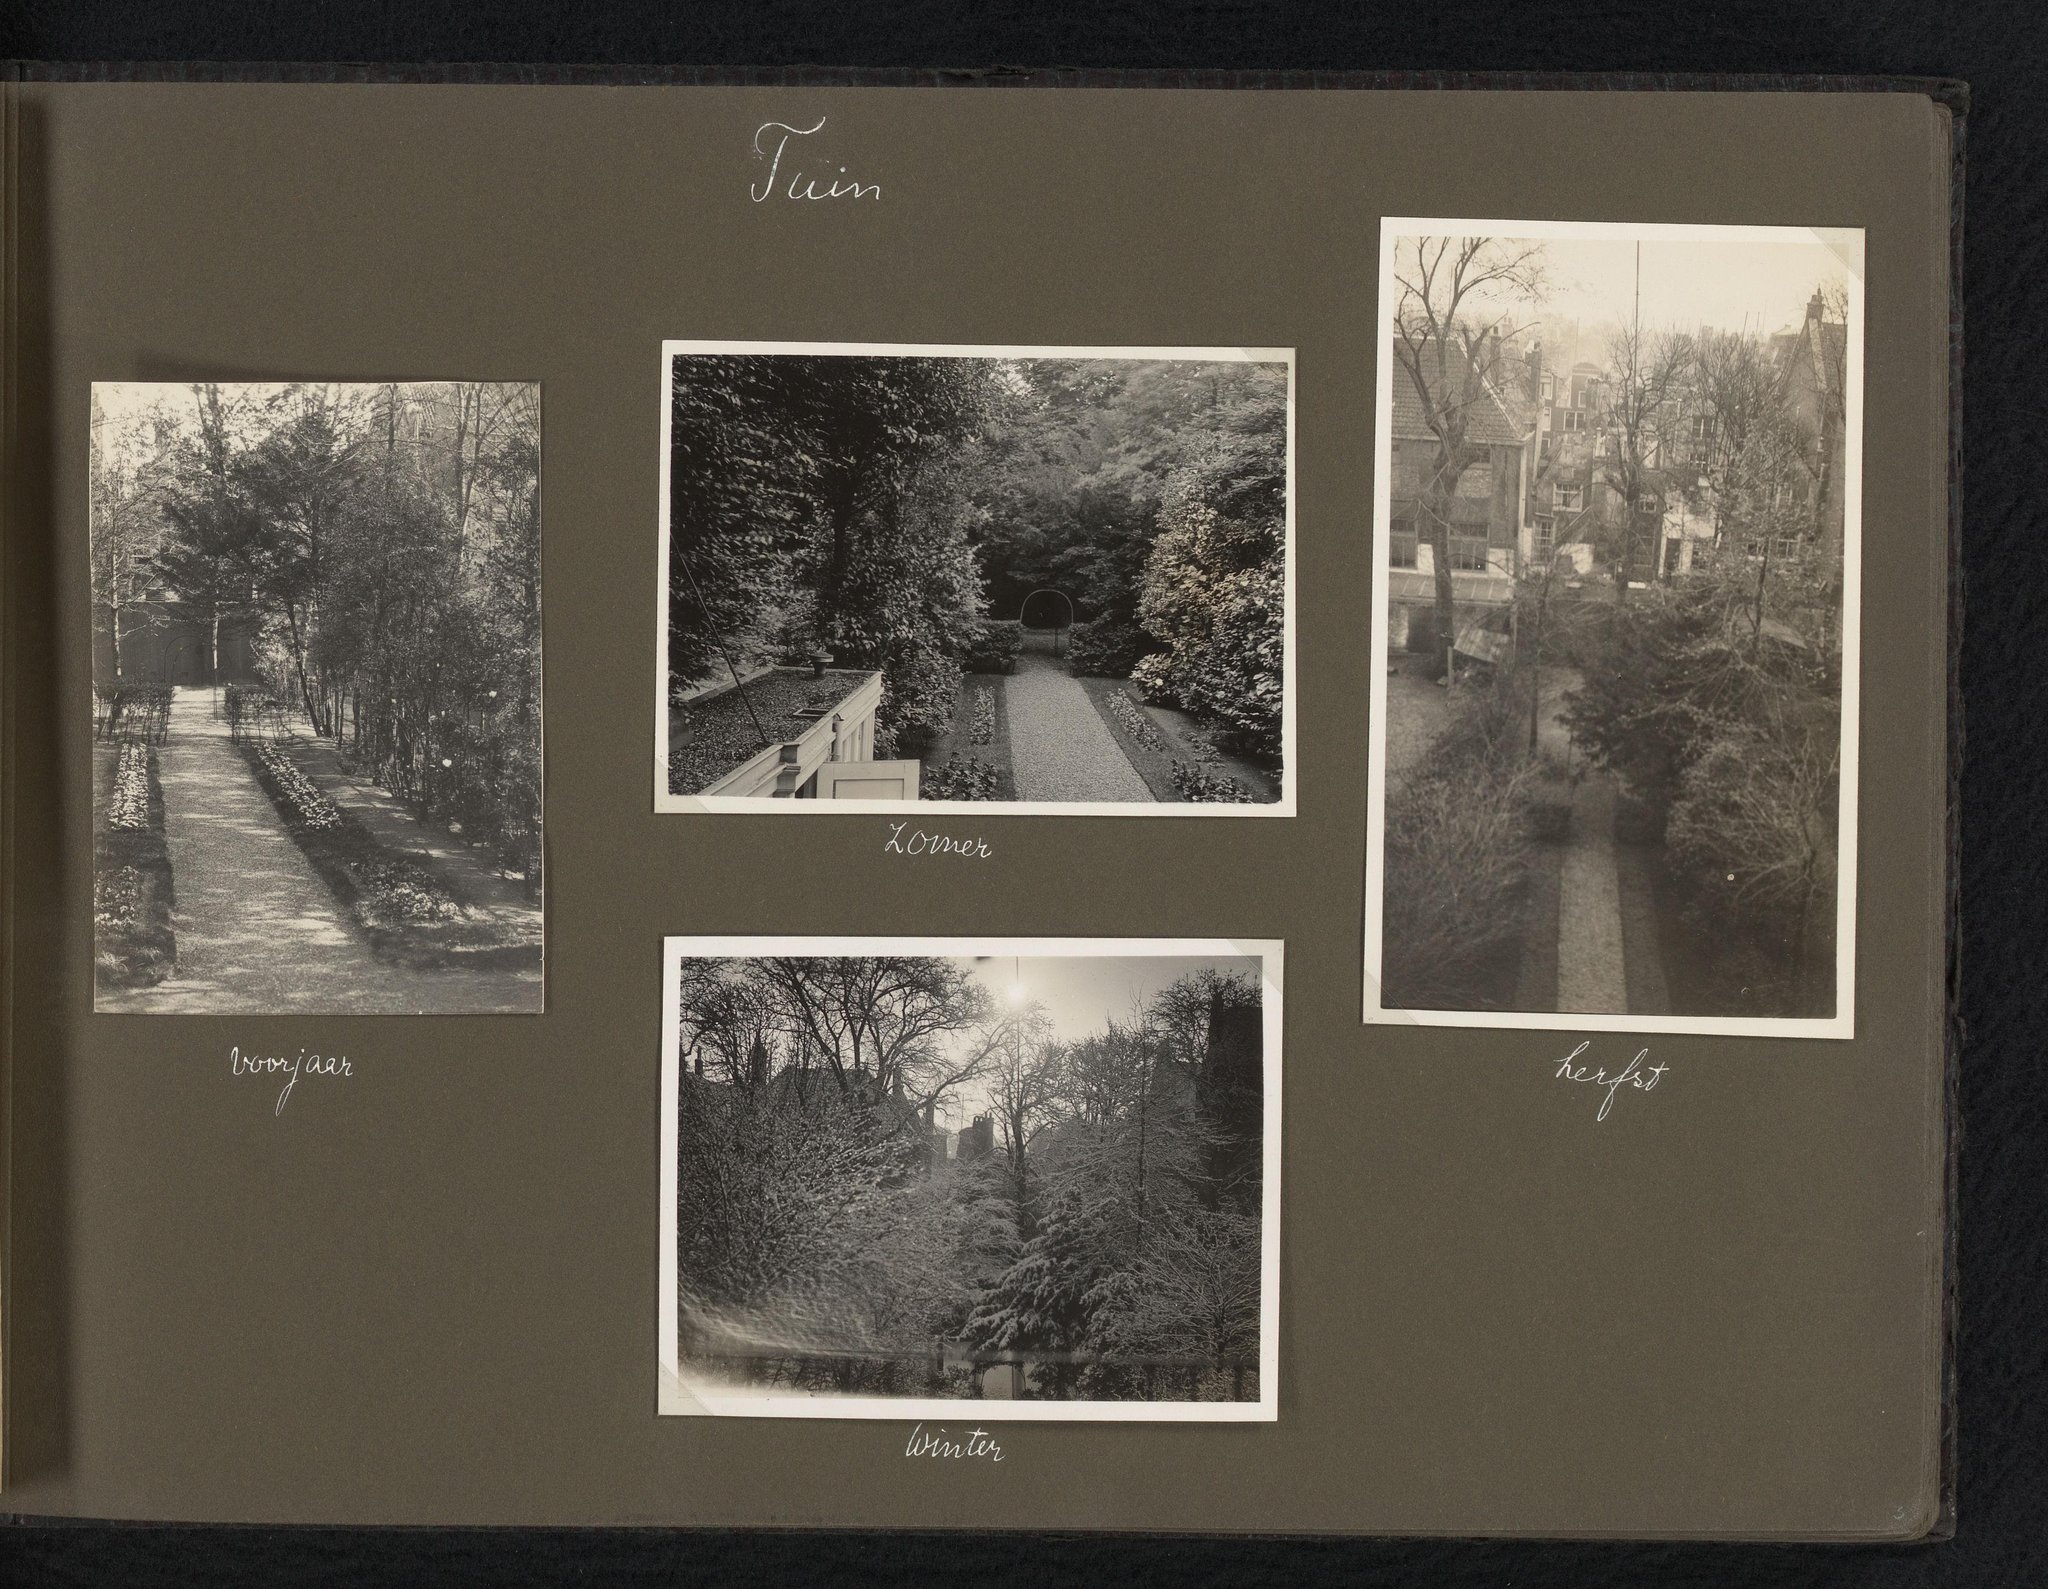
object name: photograph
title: Tuin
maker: frank willem van den berg (1912-1998)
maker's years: 1912-1998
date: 1930-1931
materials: paper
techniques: gelatin silver print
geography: amsterdam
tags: the four seasons of the year ~ landscapes, garden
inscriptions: inscription: ‘zomer’, inscription: ‘herfst’, inscription: ‘voorjaar’, inscription: ‘winter’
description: Deze foto's maken deel uit van een album.